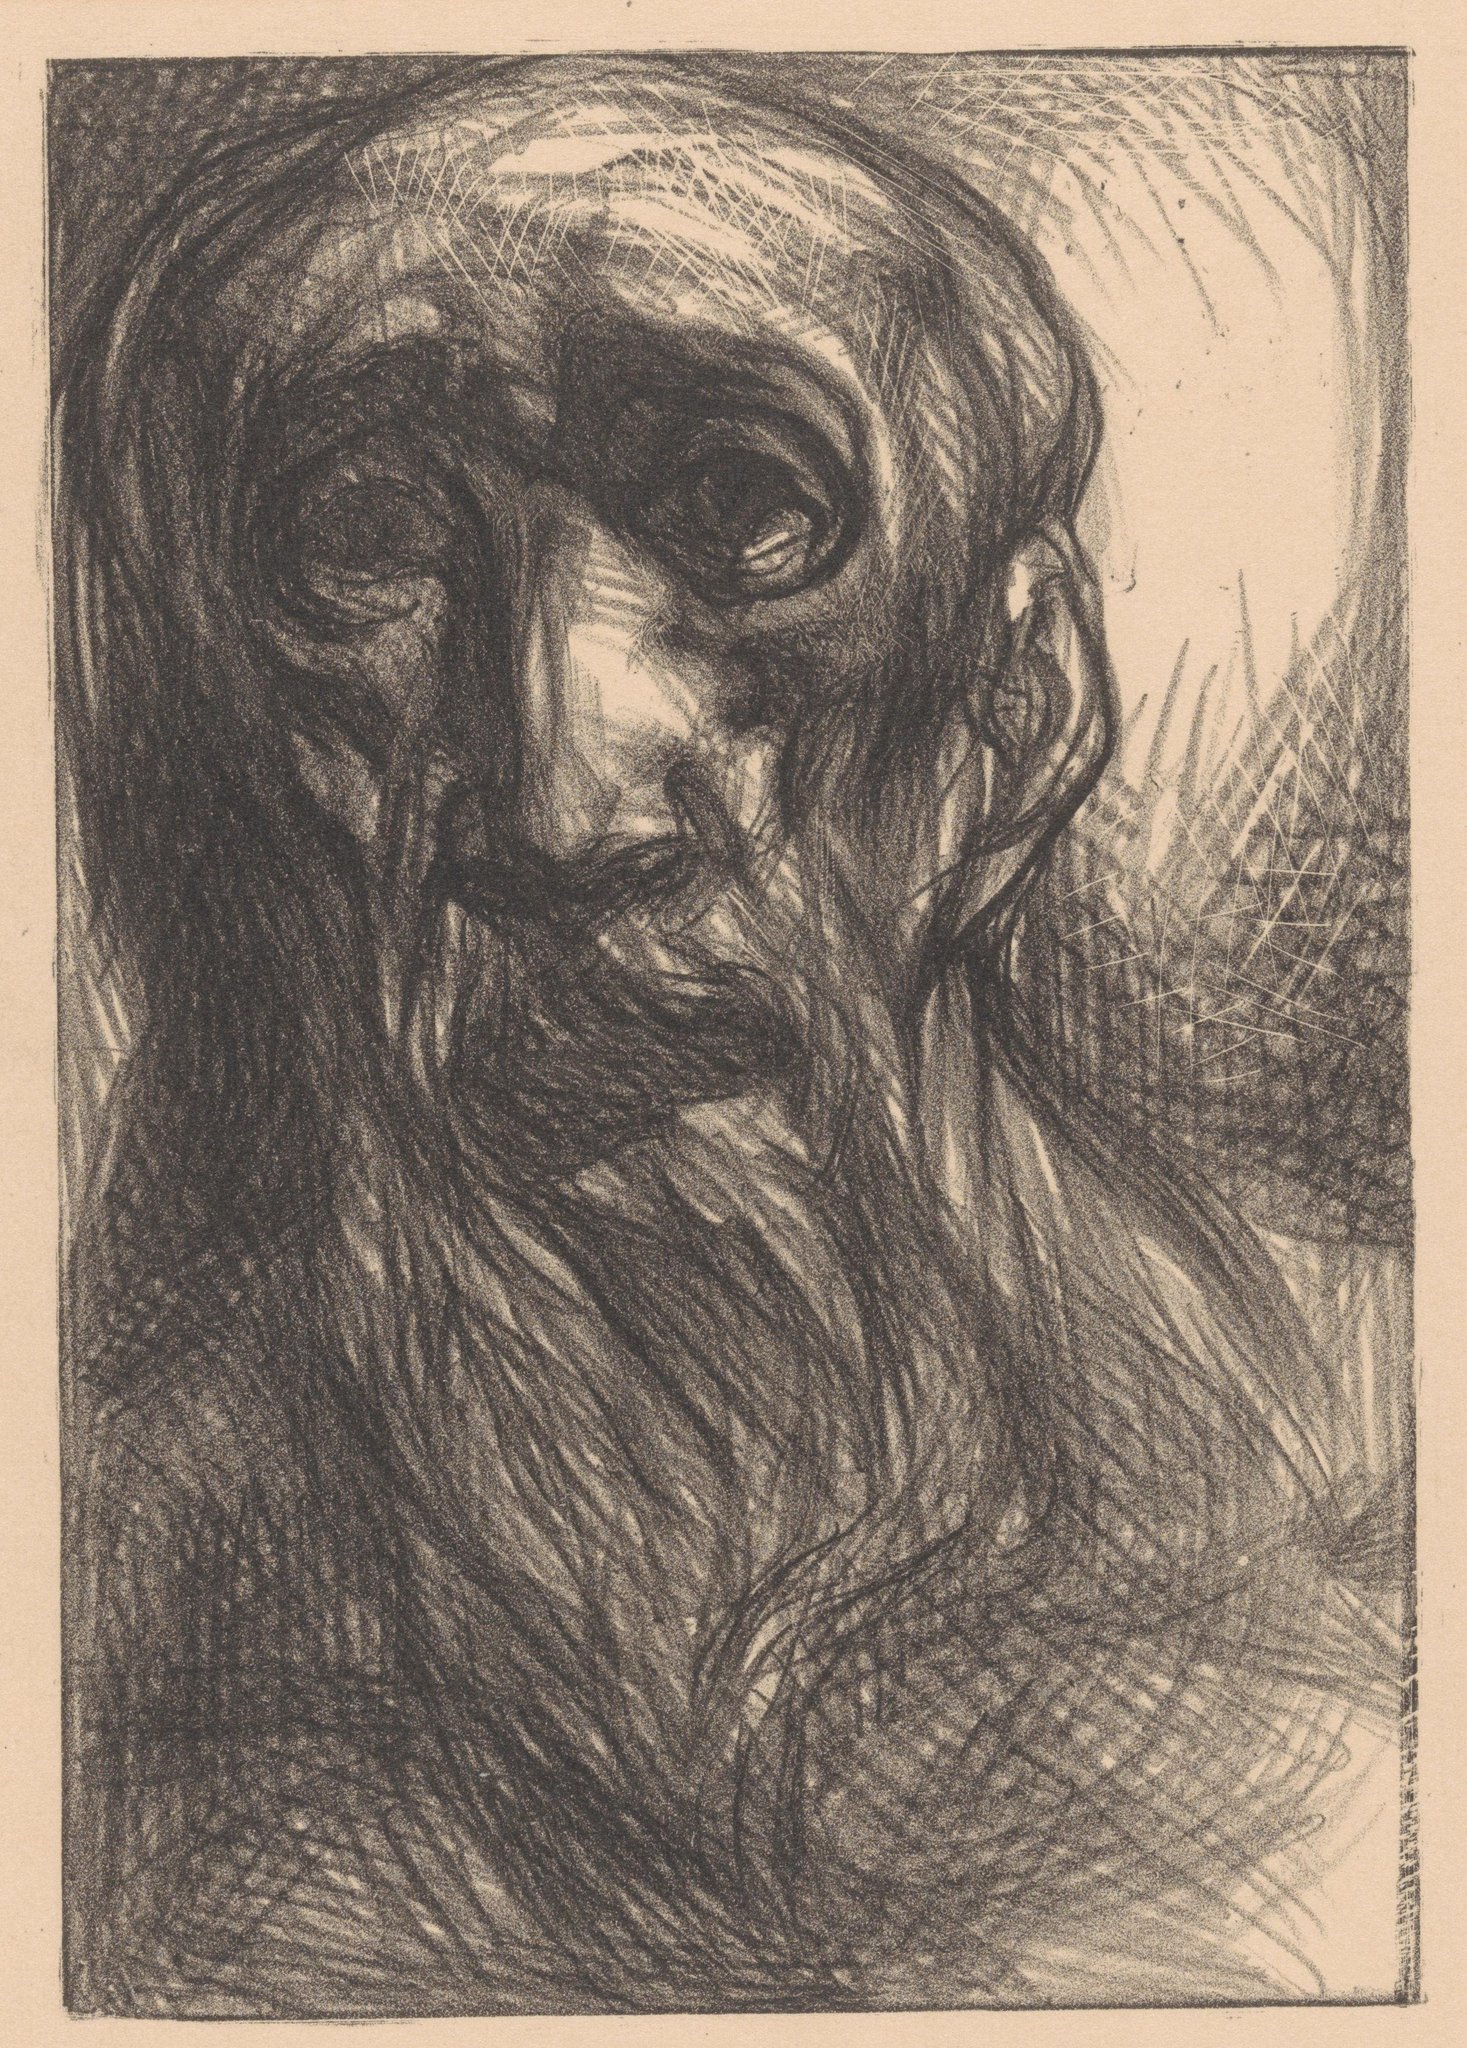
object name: print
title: Hoofd van bebaarde man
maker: johannes josephus aarts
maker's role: draughtsman, print maker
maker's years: 1871-1934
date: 1927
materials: paper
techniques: lithograph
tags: head (human), beard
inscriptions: collector's mark: Lugt 2228